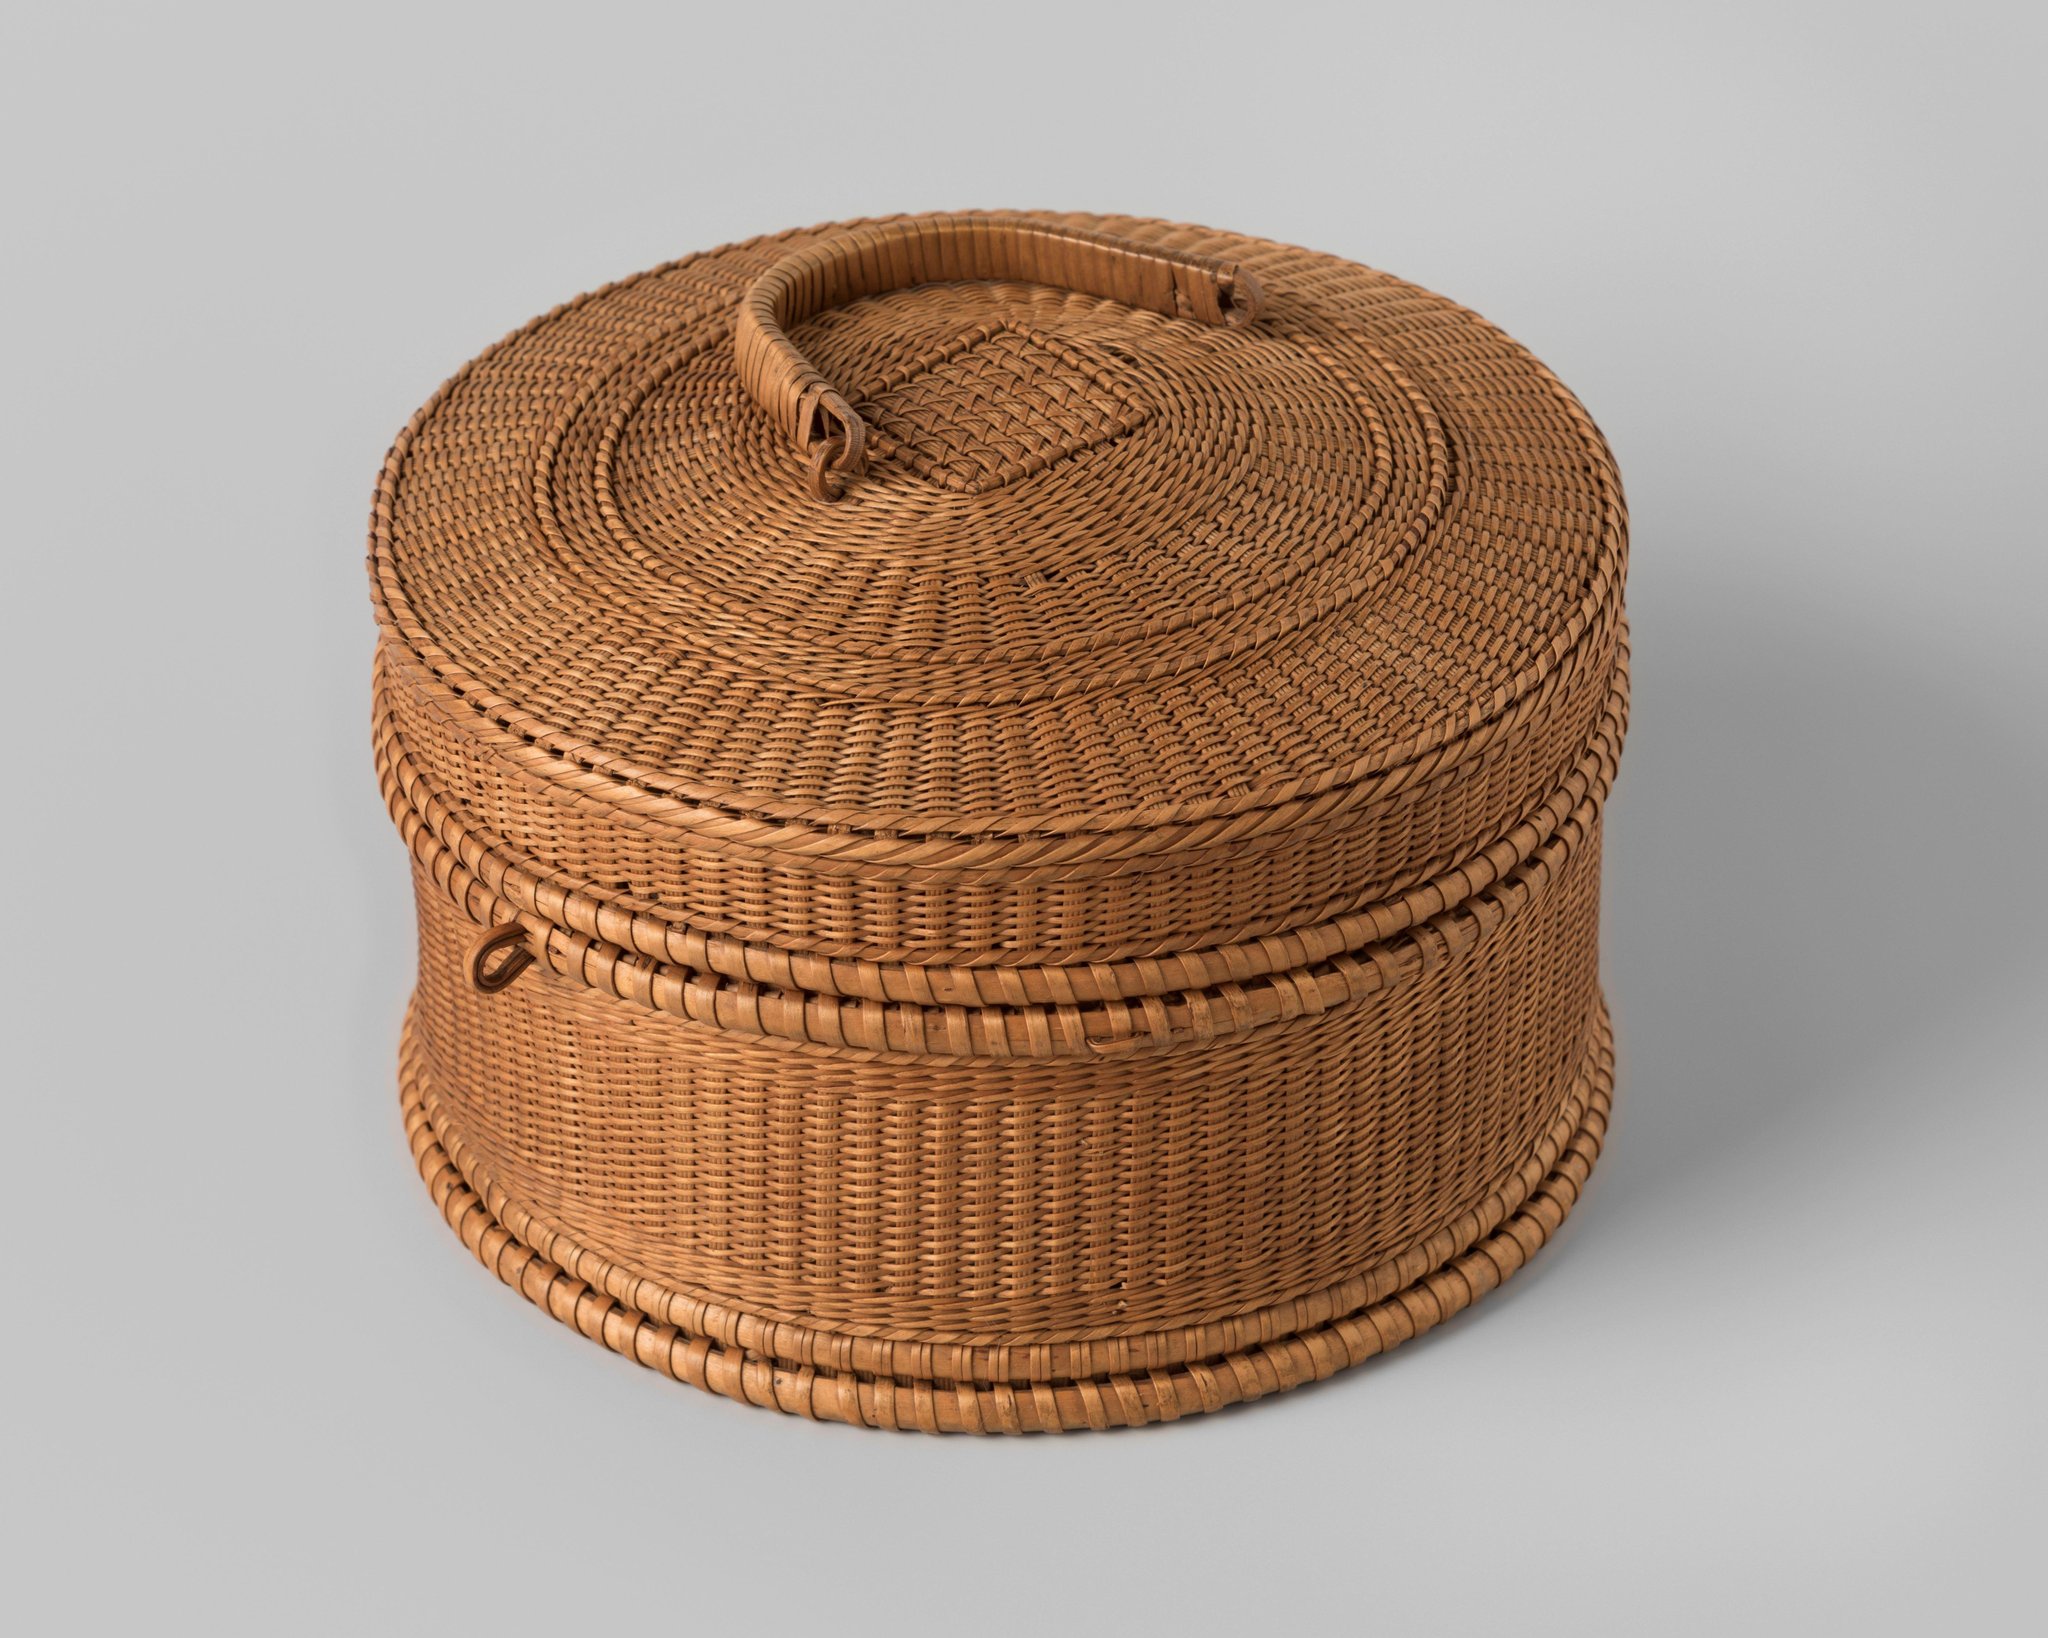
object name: sewing basket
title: Naaimand van gevlochten stro, bekleed met felblauwe ponjé-zijde; gewatteerd en doorgestikt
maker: Anonymous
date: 1850-1900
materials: textile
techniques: braiding, padding, quilting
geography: netherlands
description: Naaimand van gevlochten stro. Cylindermodel met deksel. Het deksel, de bodem en de wanden zijn bekleed met felblauwe doorgestikte ponjé-zijde en watten. Deksel en bodem in wit garen. In de wanden drie zakjes voor klosjes en een speldenkussen. Afgewerkt met blauw-wit koord.